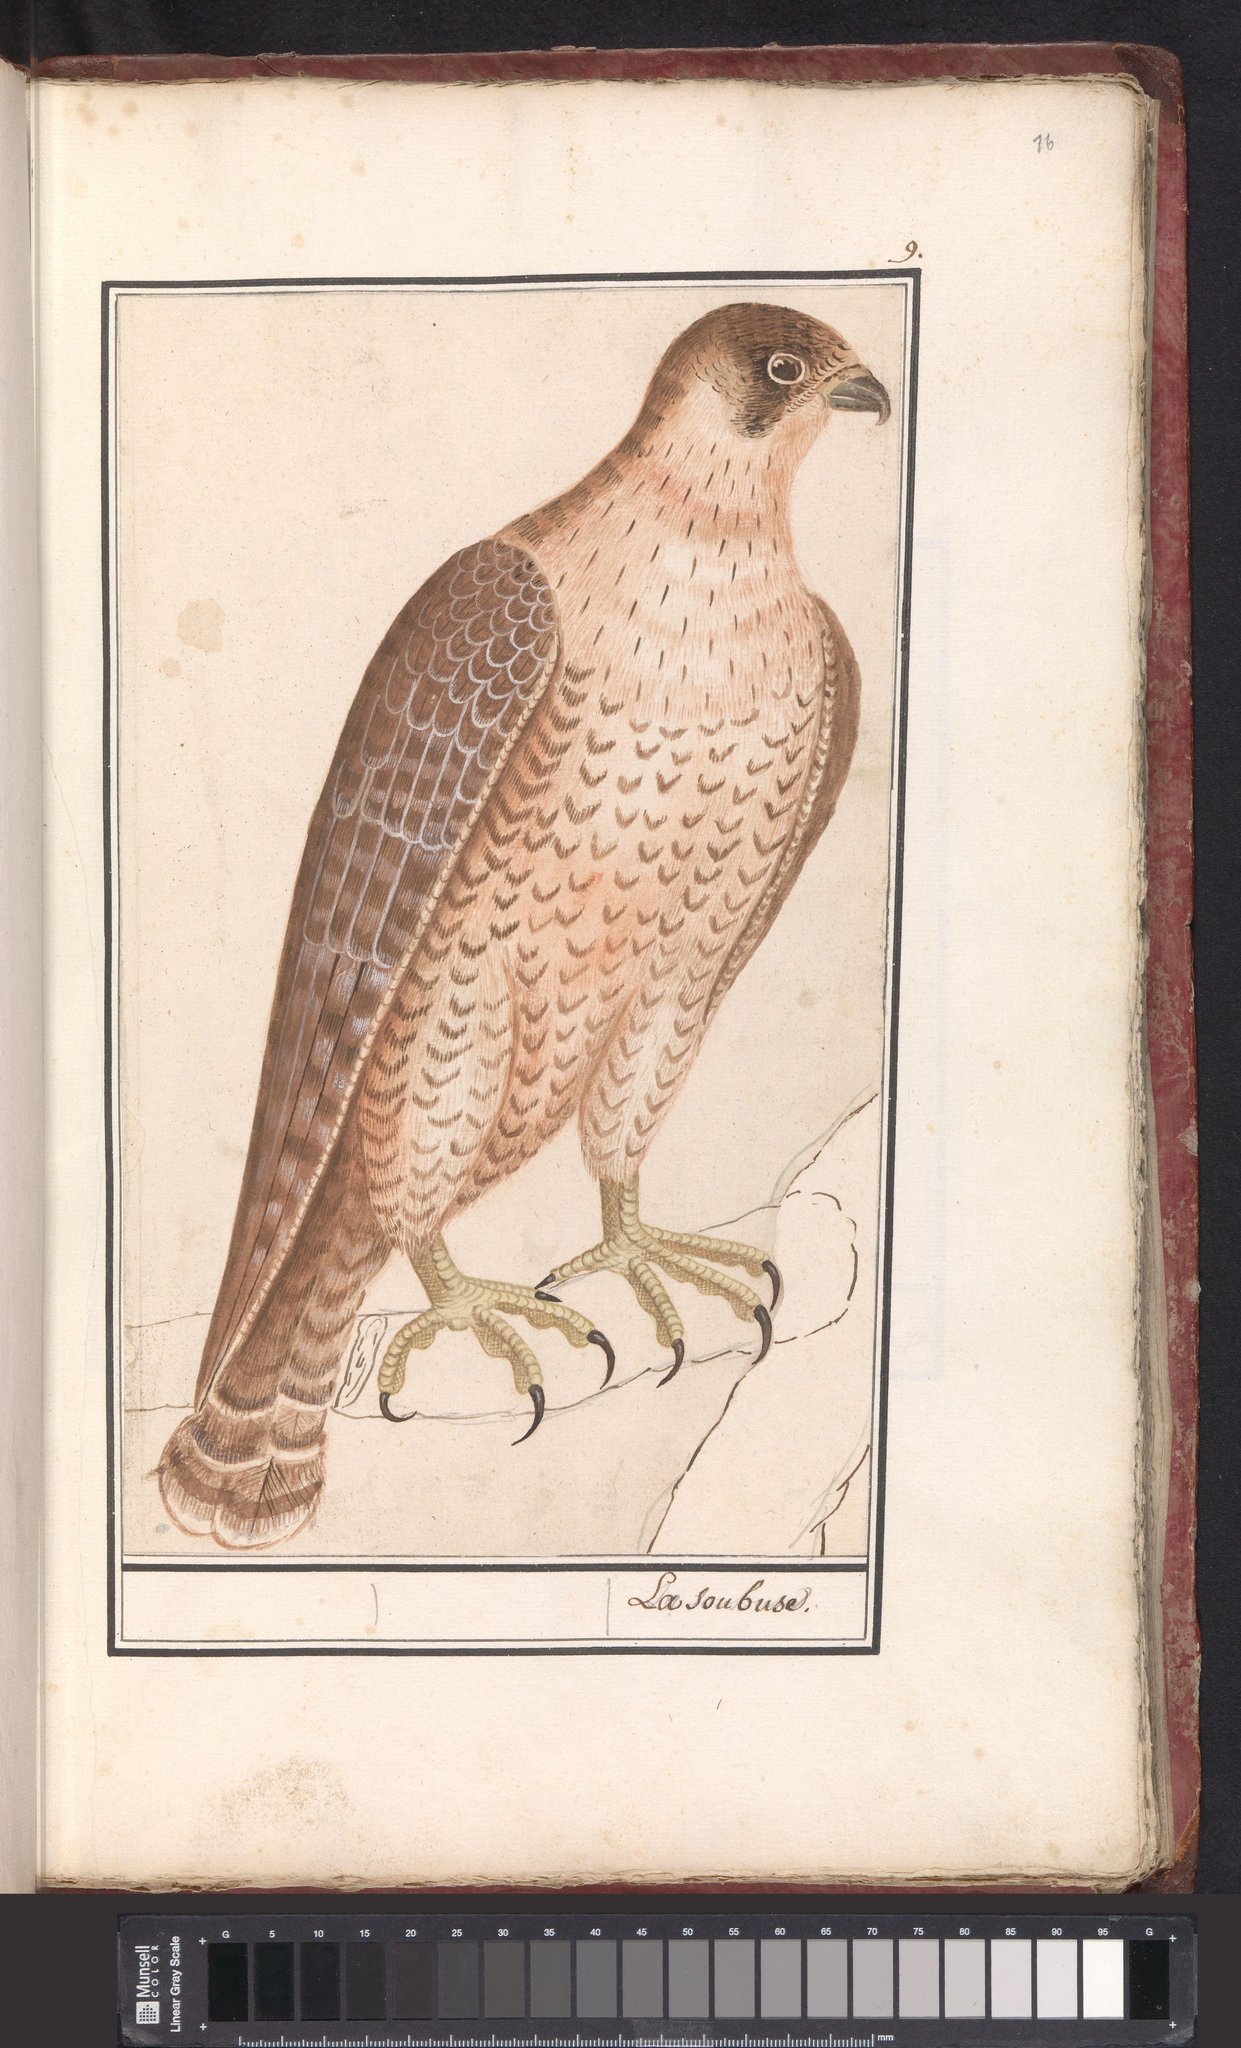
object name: drawing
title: Saker Falcon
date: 1596-1610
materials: paint, paper, pencil, watercolor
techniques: brush, pen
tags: predatory birds: saker falcon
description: Sakervalk (?). Genummerd rechtsboven: 9. Onderdeel van het eerste album met tekeningen van vogels. Derde van twaalf albums met tekeningen van dieren, vogels en planten bekend rond 1600, gemaakt in opdracht van keizer Rudolf II. Met toelichting in Nederlands, Latijn en Frans.